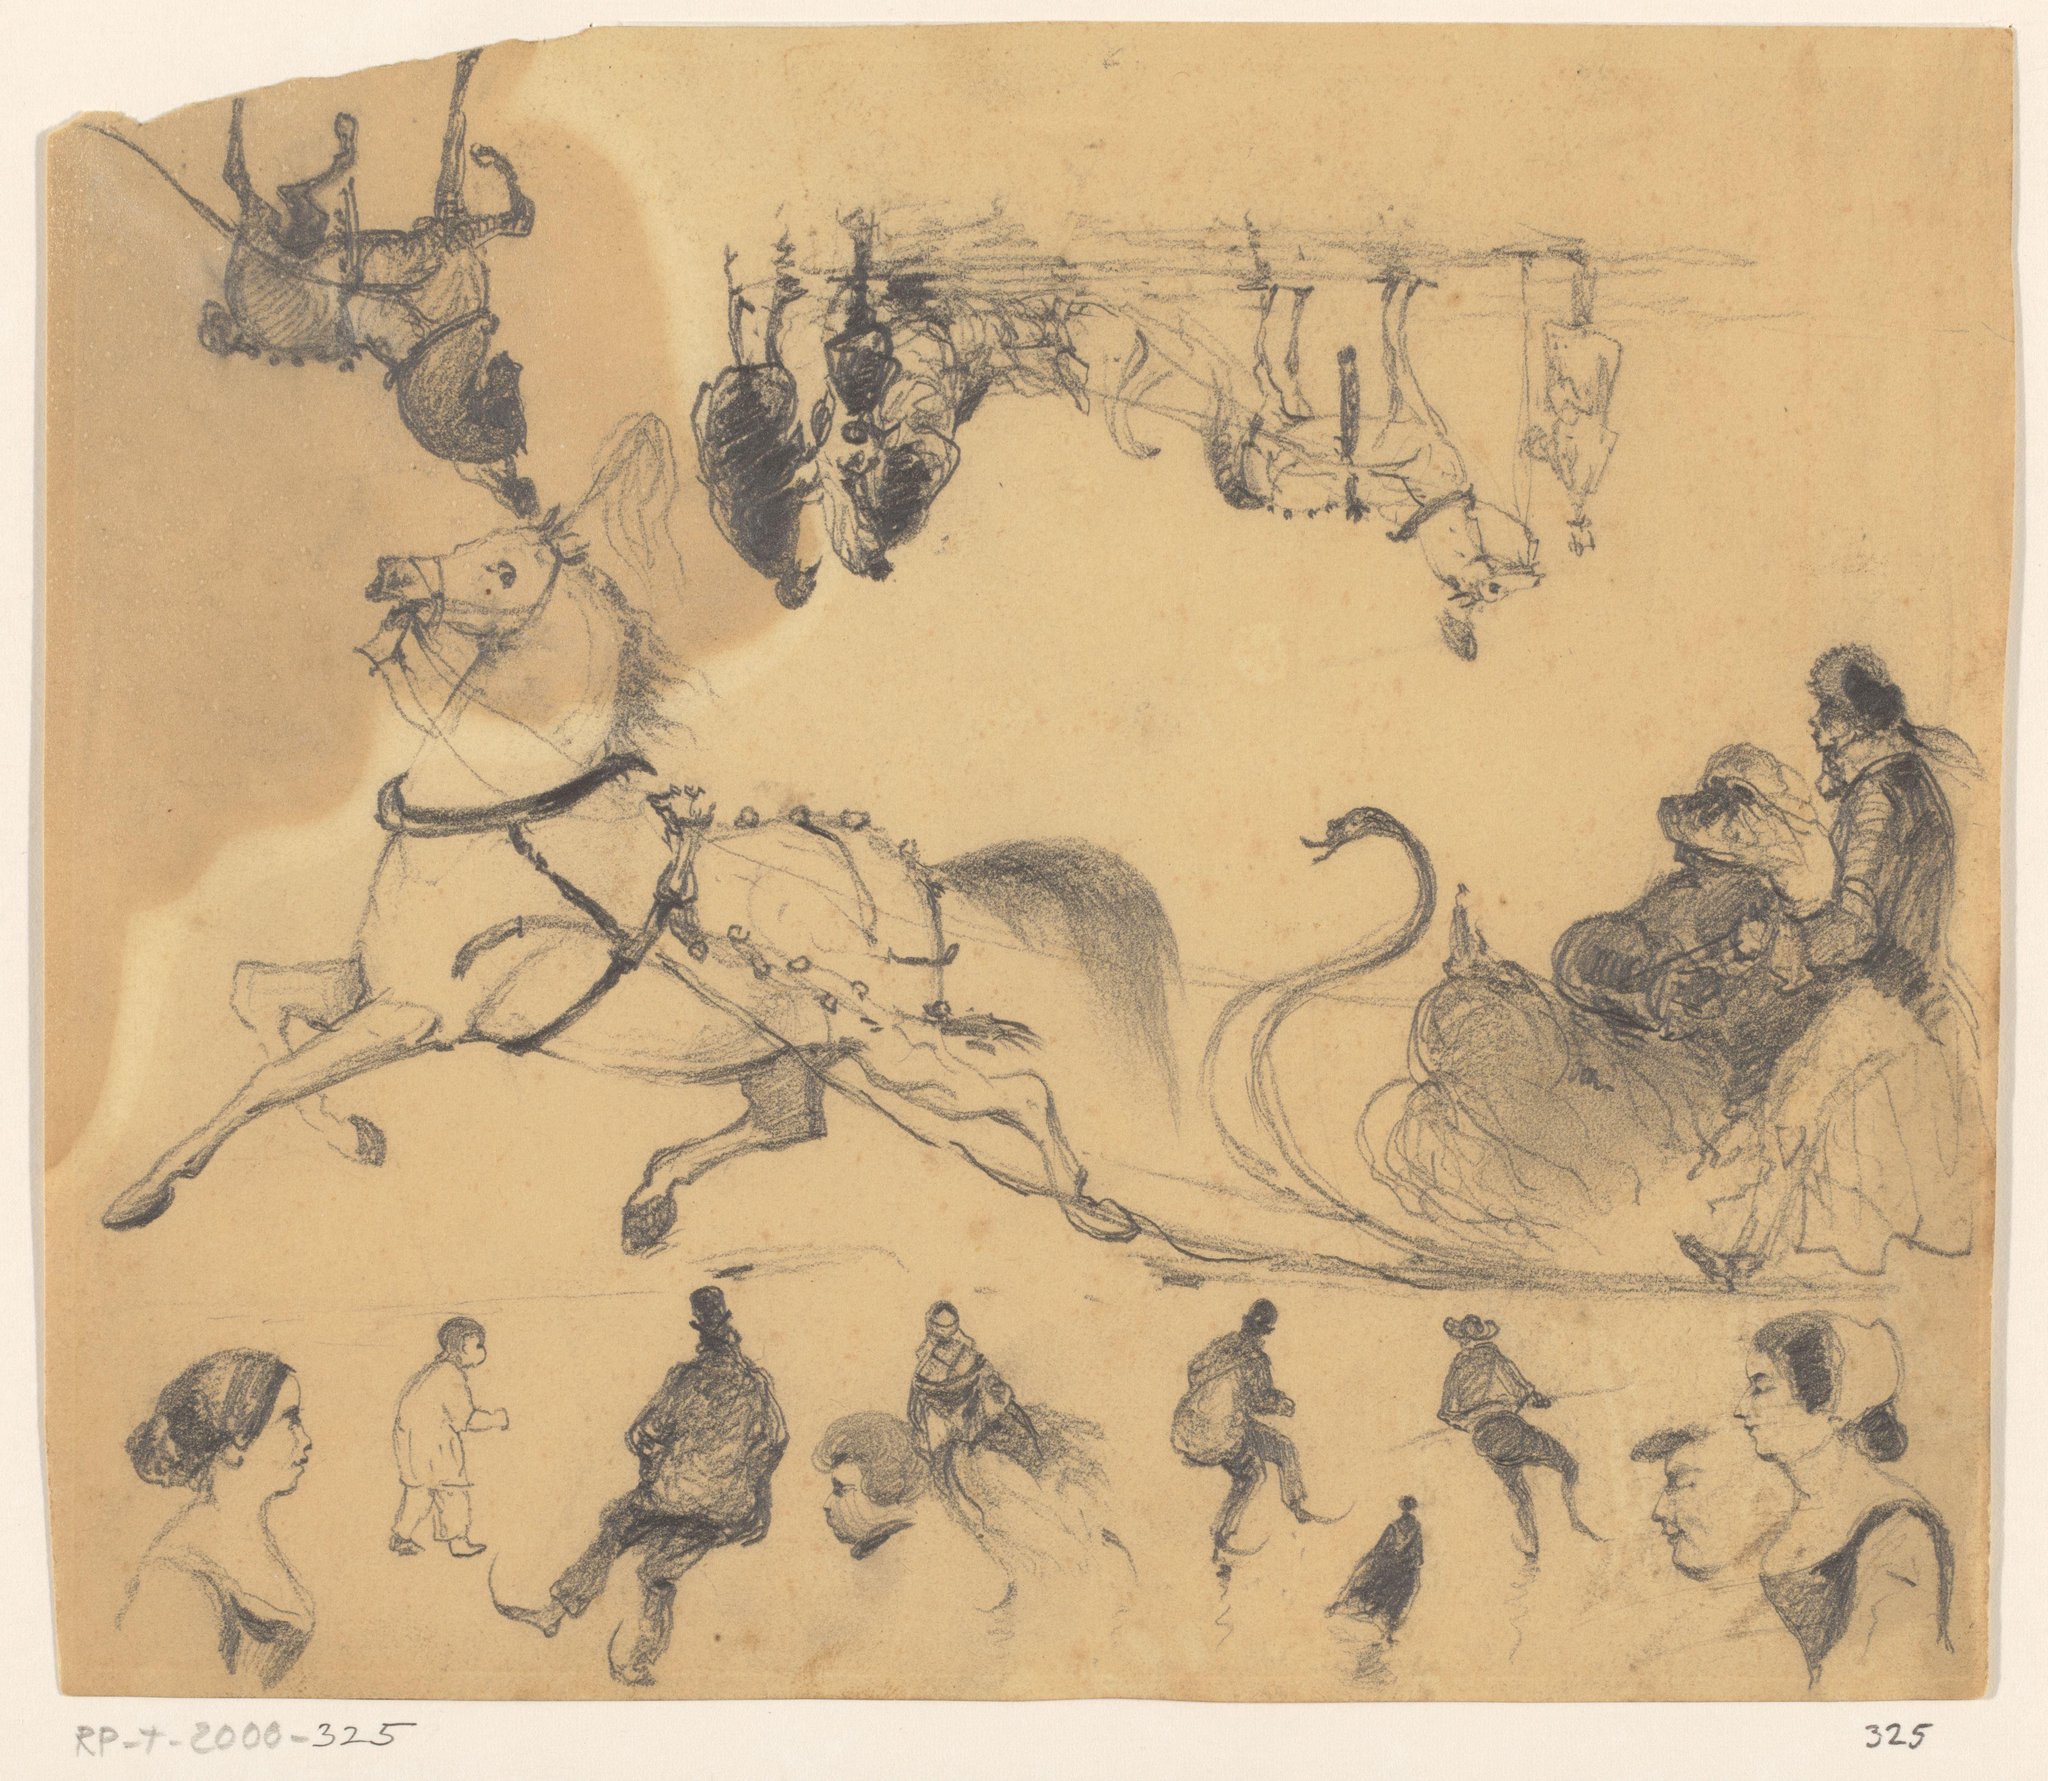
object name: envelope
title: Arrenslede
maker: johannes tavenraat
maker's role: draughtsman, painter, print maker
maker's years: 1809-1881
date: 1840-1880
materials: paper, pencil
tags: horse-sleigh, skates (winter sports)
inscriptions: collector's mark: Lugt 2228